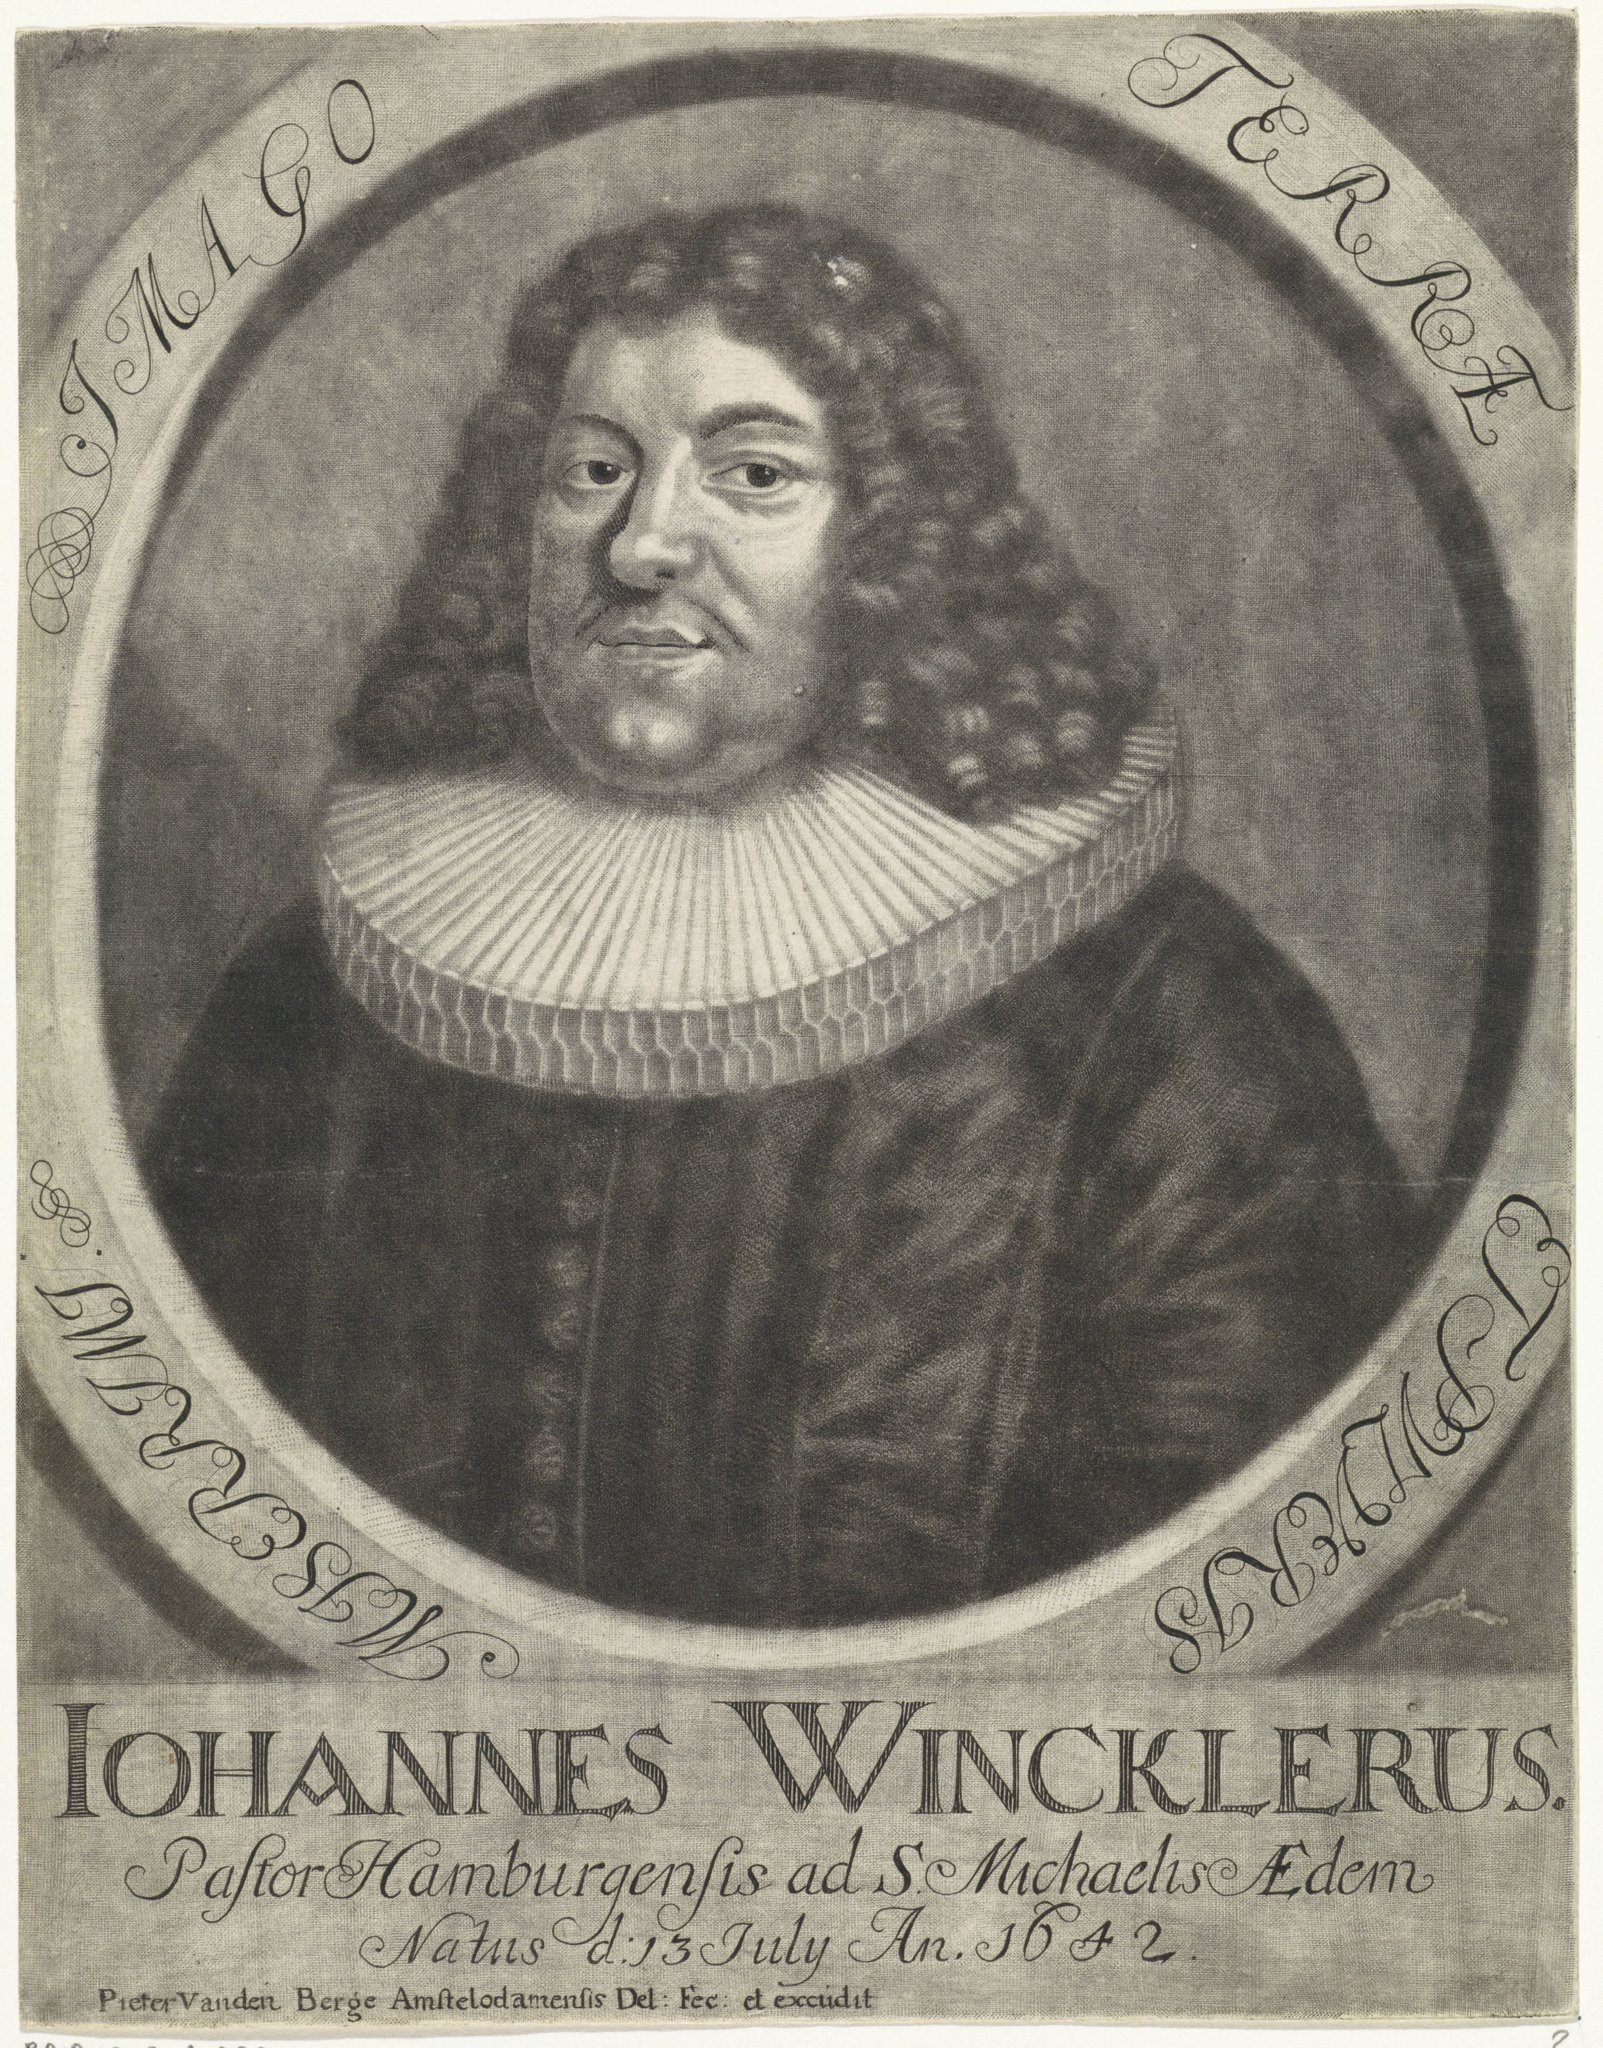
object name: print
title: Portret van Johann Winckler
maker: pieter van den berge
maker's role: draughtsman, print maker, printer, publisher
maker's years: 1659-1737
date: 1692-1737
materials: paper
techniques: engraving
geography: amsterdam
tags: golzern, hamburg, luthers theoloog, johann winckler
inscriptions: collector's mark: Lugt 2228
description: Portret van Johann Winckler, predikant te Hamburg en professor in oriëntaalse talen. In de marge zijn naam, titels en geboortedata. In de omlijsting zijn motto.